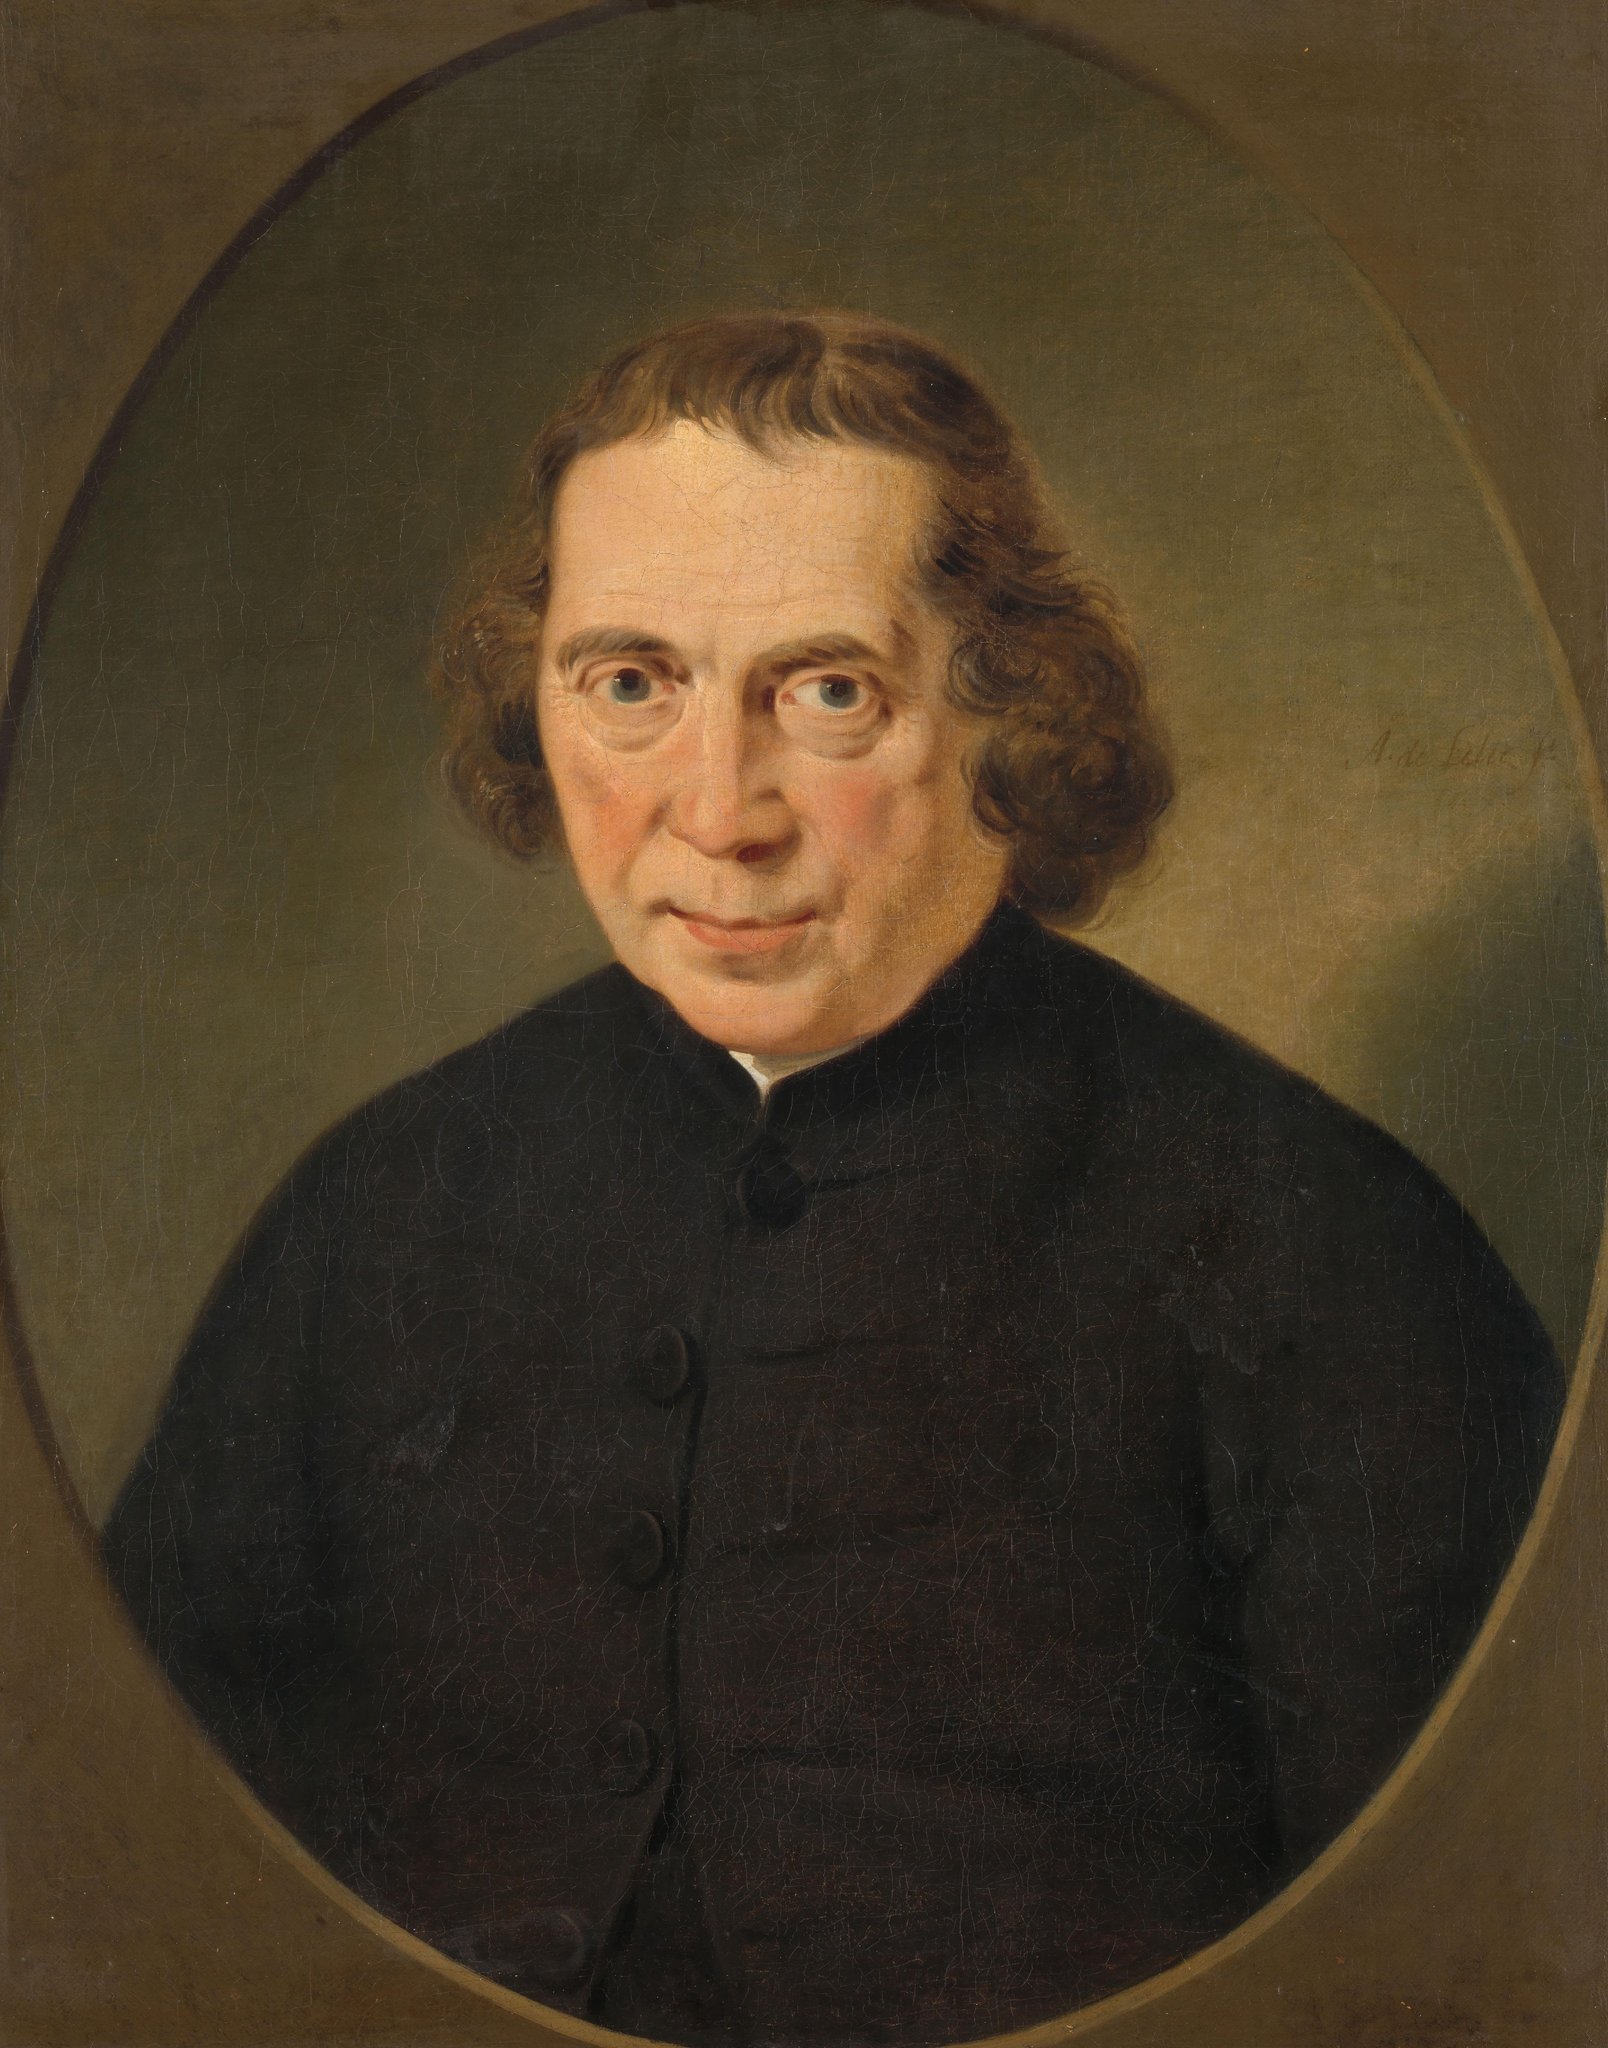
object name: painting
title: Portrait of Jan Nieuwenhuyzen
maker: adriaan de lelie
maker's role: draughtsman, painter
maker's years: 1755-1820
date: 1780-1806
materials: canvas, oil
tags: haarlem, jan nieuwenhuyzen, historical persons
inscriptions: signature: ‘A. de Lelie ft.’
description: Jan Nieuwenhuyzen was a bookseller, printer and Mennonite preacher. Together with a few kindred spirits, in 1784 he founded the Maatschappij tot Nut van ’t Algemeen (Society for Public Advancement). The society strove to raise the spiritual and moral level of society, mainly by contributing to the improvement of general education.